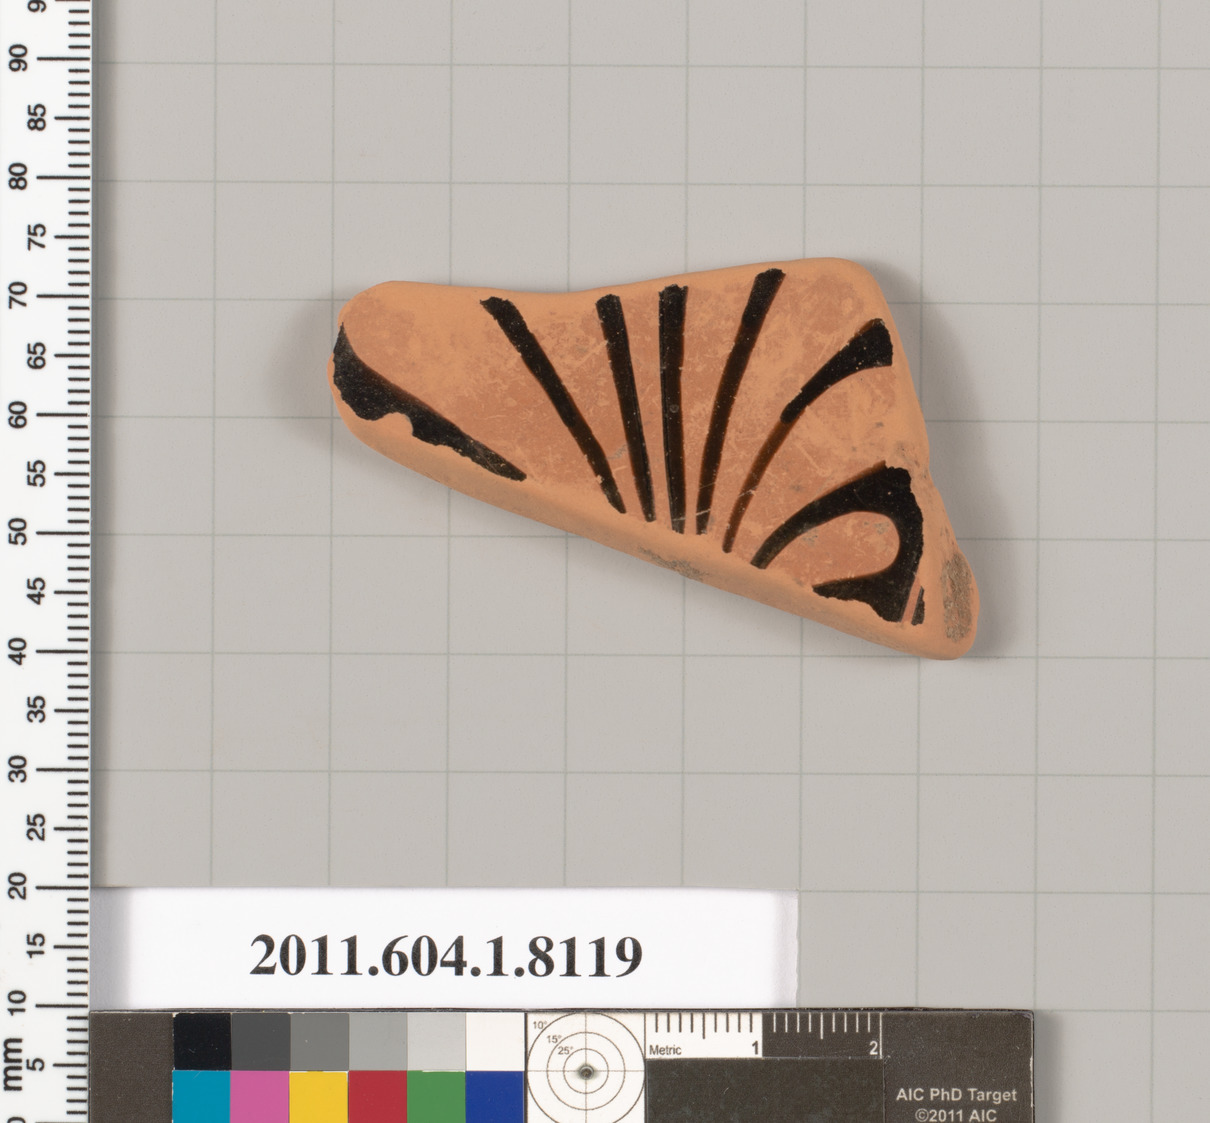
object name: kylix fragment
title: Terracotta fragment of a kylix (drinking cup)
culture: greek, attic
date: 534-468 BCE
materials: terracotta